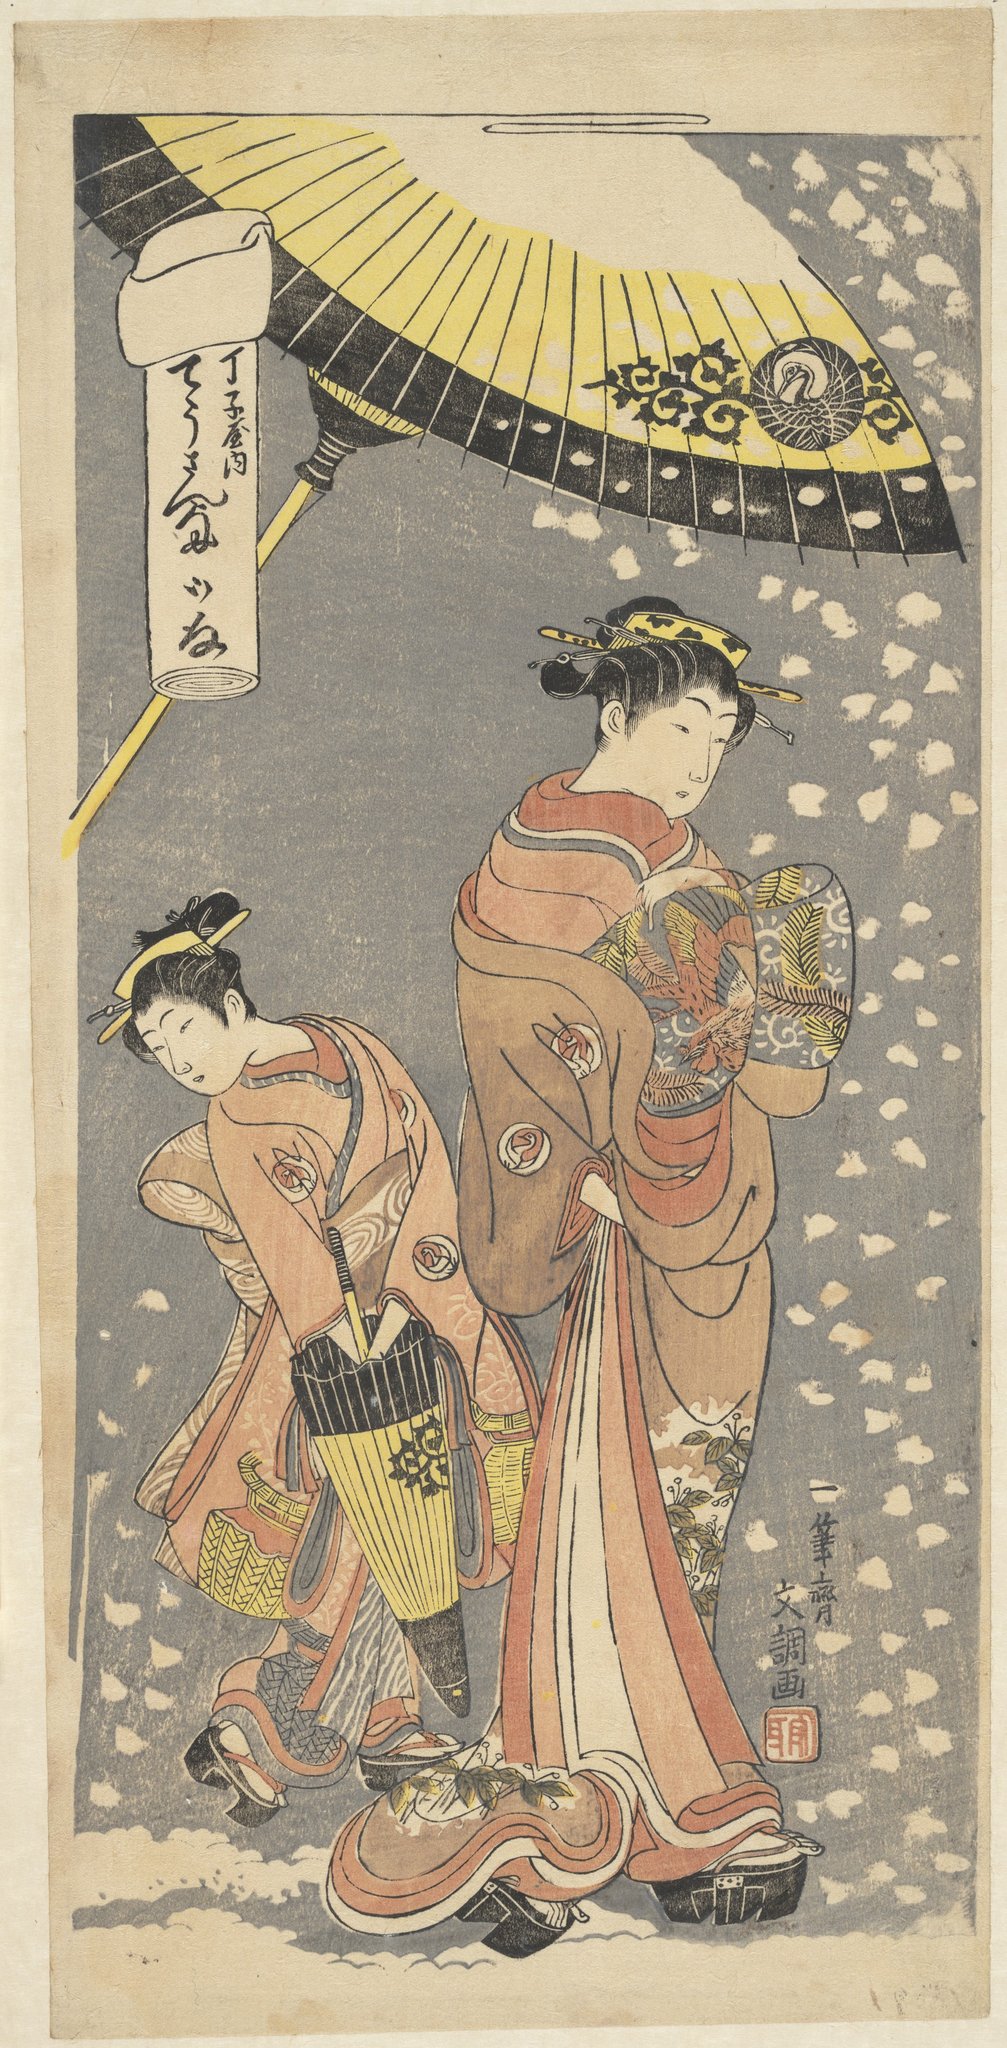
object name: print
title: The Oiran Chōzan of Chōjiya, from the series Love Letters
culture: japanese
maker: ippitsusai bunchō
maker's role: artist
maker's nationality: japanese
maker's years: 1765-1792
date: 1769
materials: ink, paper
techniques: woodblock print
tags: women